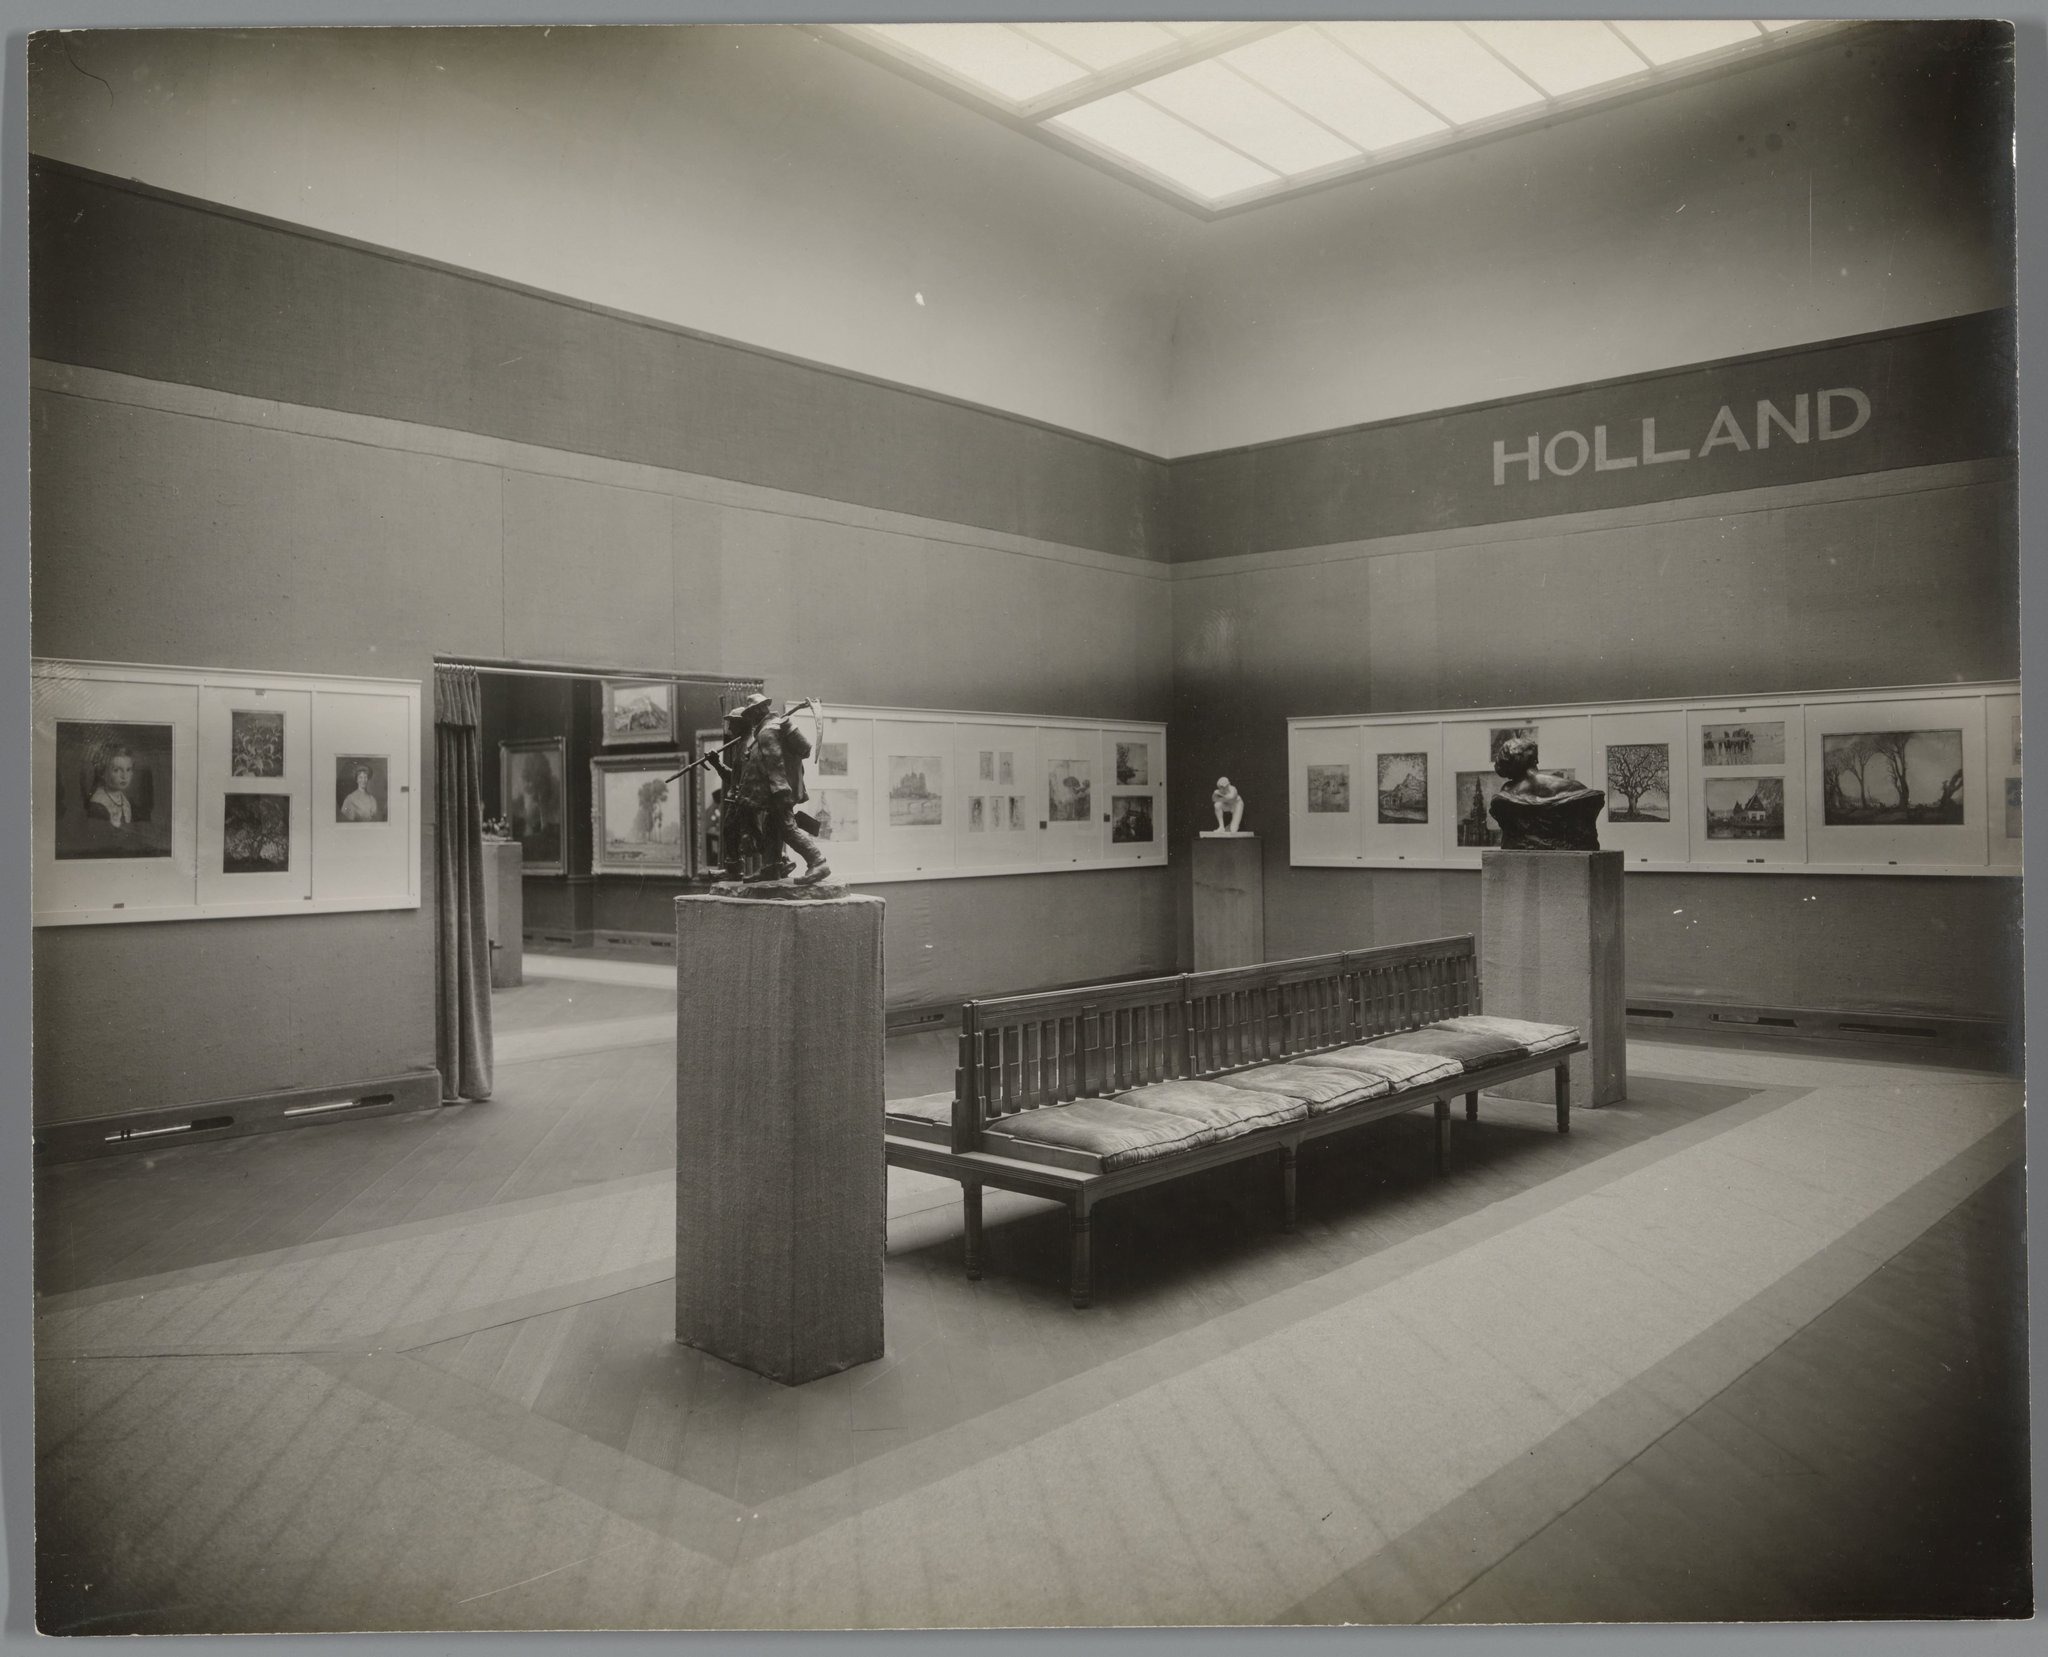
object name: photograph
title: Nederlandse zalen op de Panama-Pacific International exposition te San Francisco, 1915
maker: willem witsen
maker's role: draughtsman, painter, print maker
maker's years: 1860-1923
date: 1915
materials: paper, photographic support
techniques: gelatin silver print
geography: san francisco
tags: san francisco